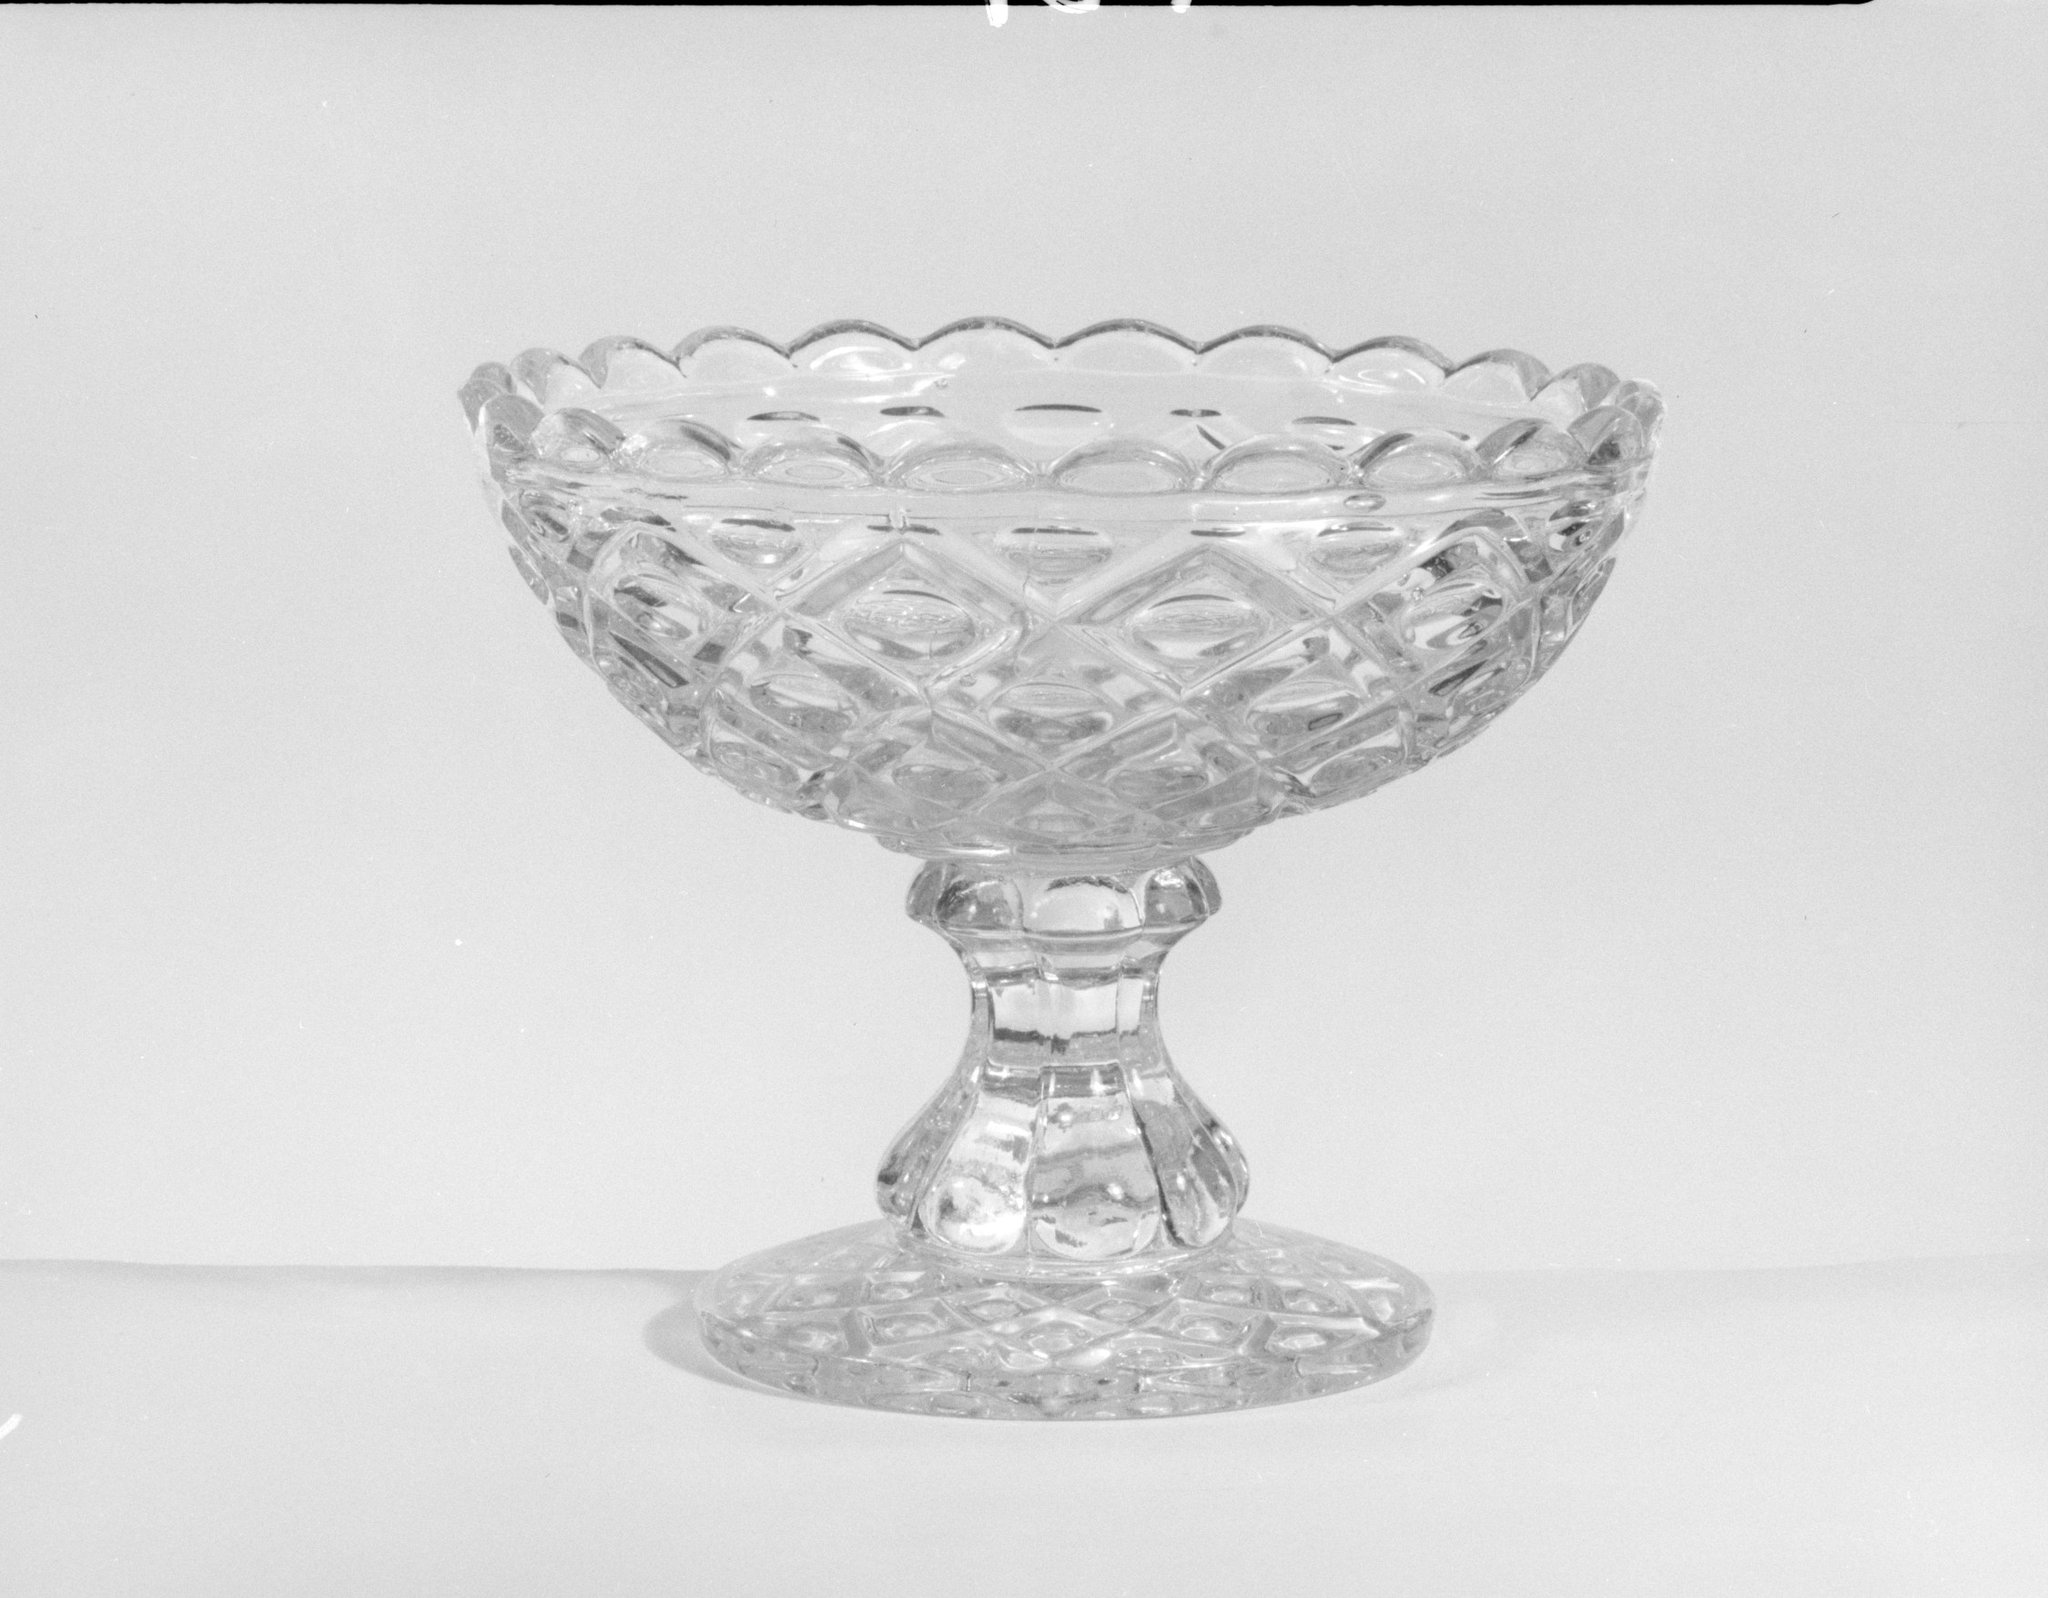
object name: compote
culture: american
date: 1850-1870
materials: glass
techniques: pressed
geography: united states